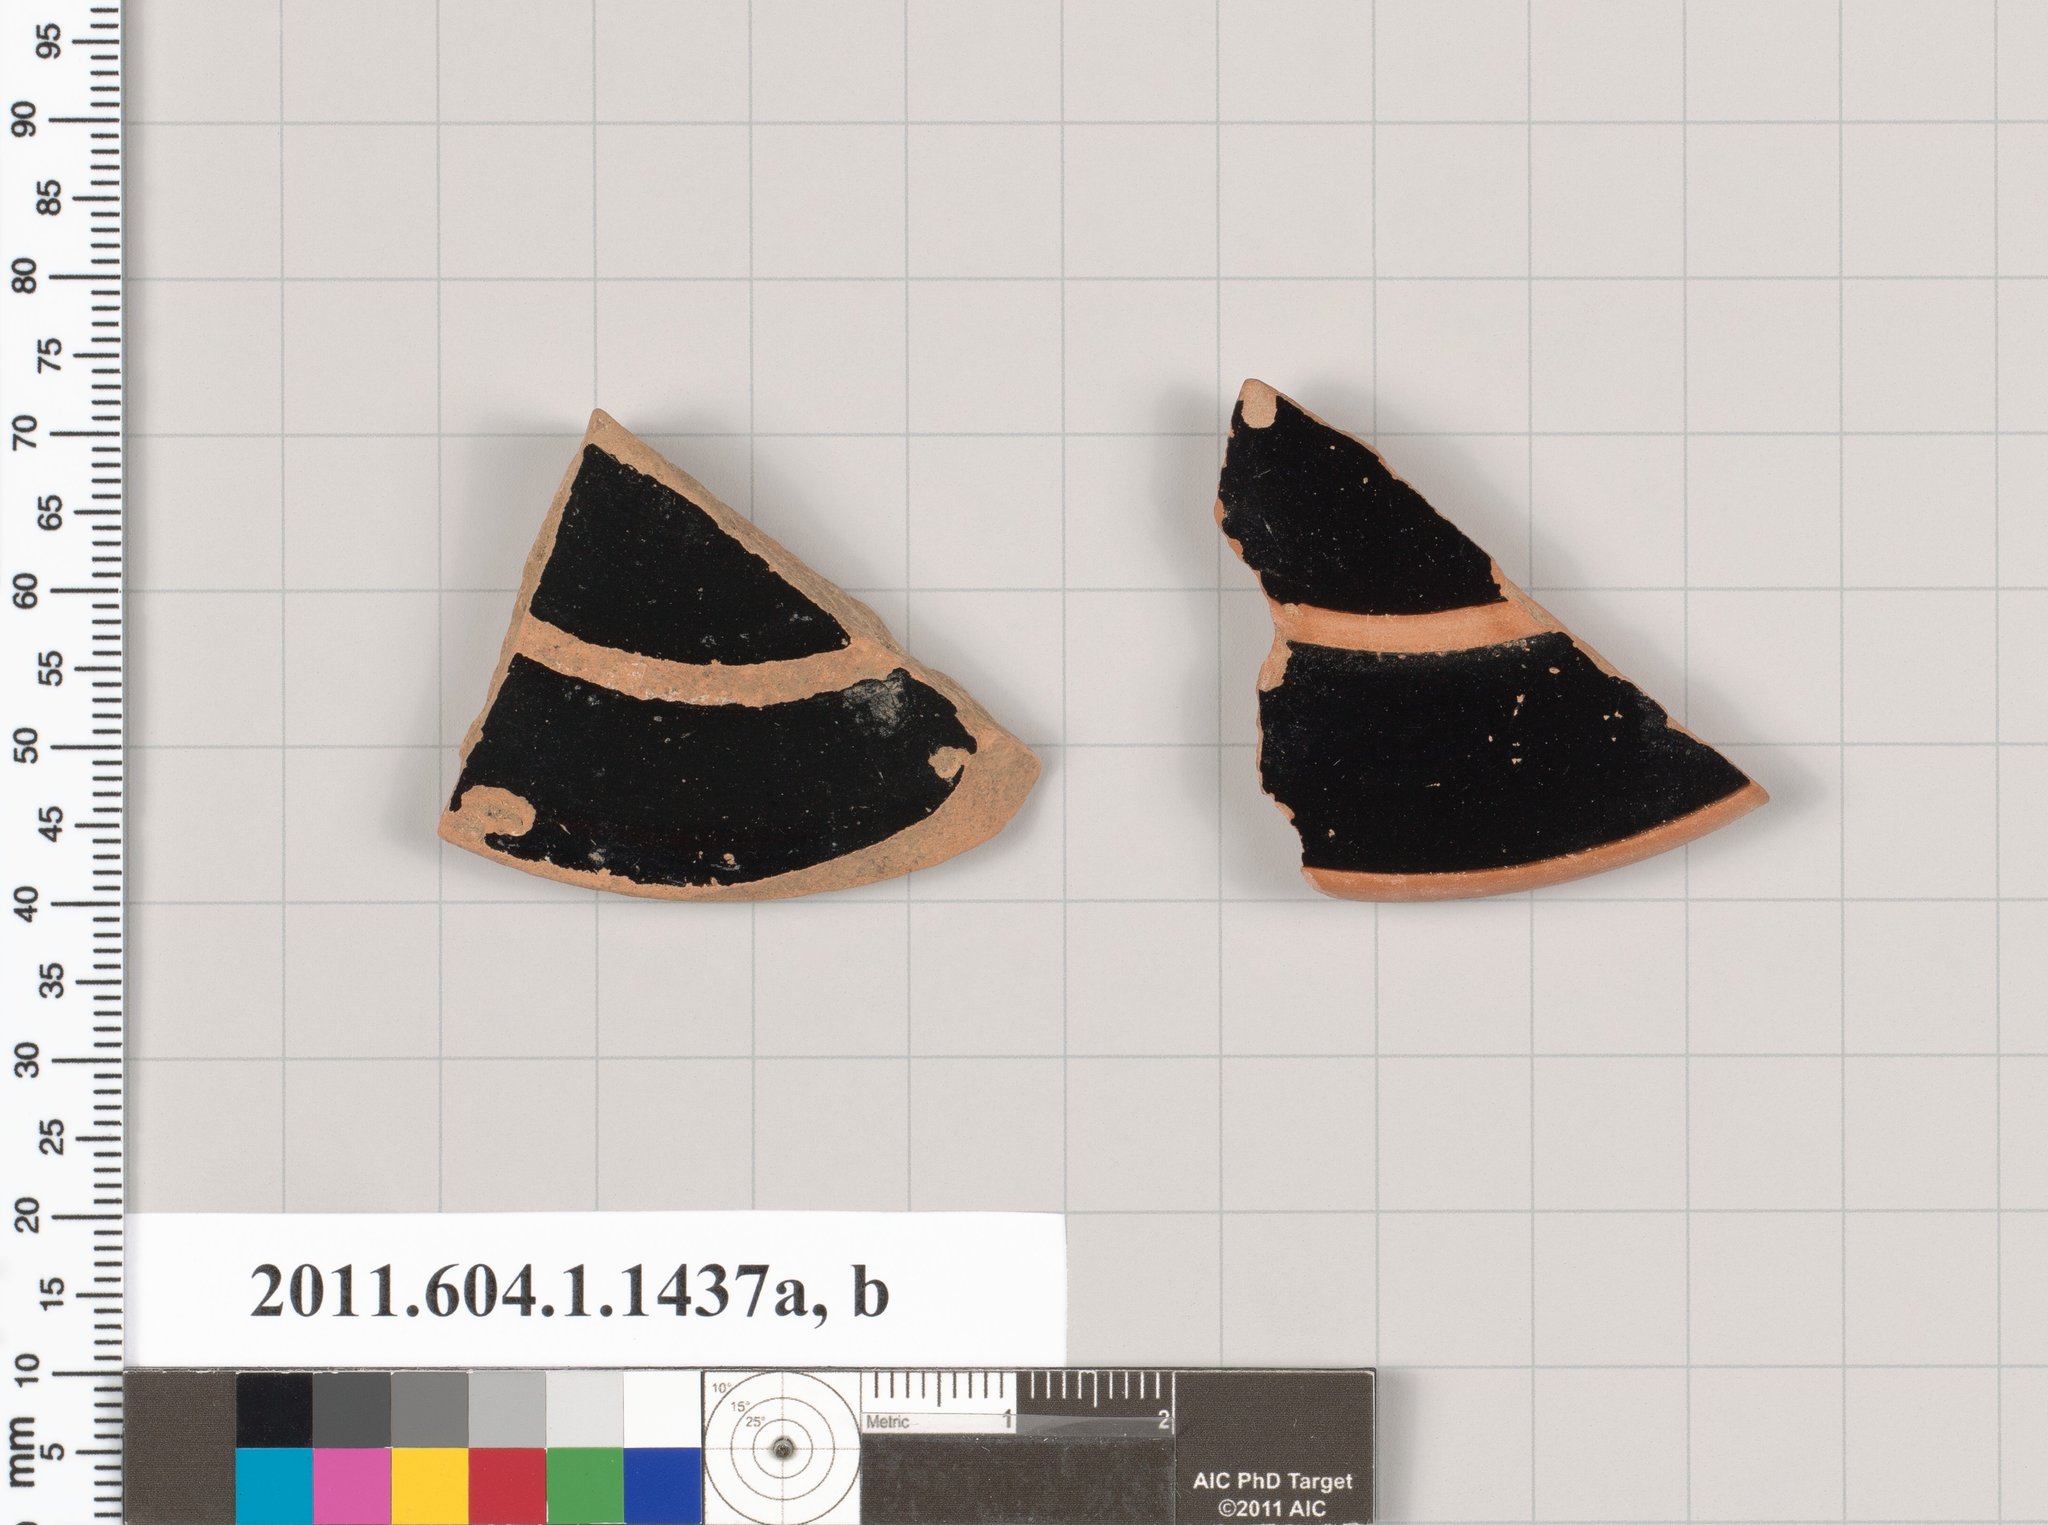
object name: kylix fragment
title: Terracotta fragments of kylikes (drinking cups)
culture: greek, attic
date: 500-401 BCE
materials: terracotta